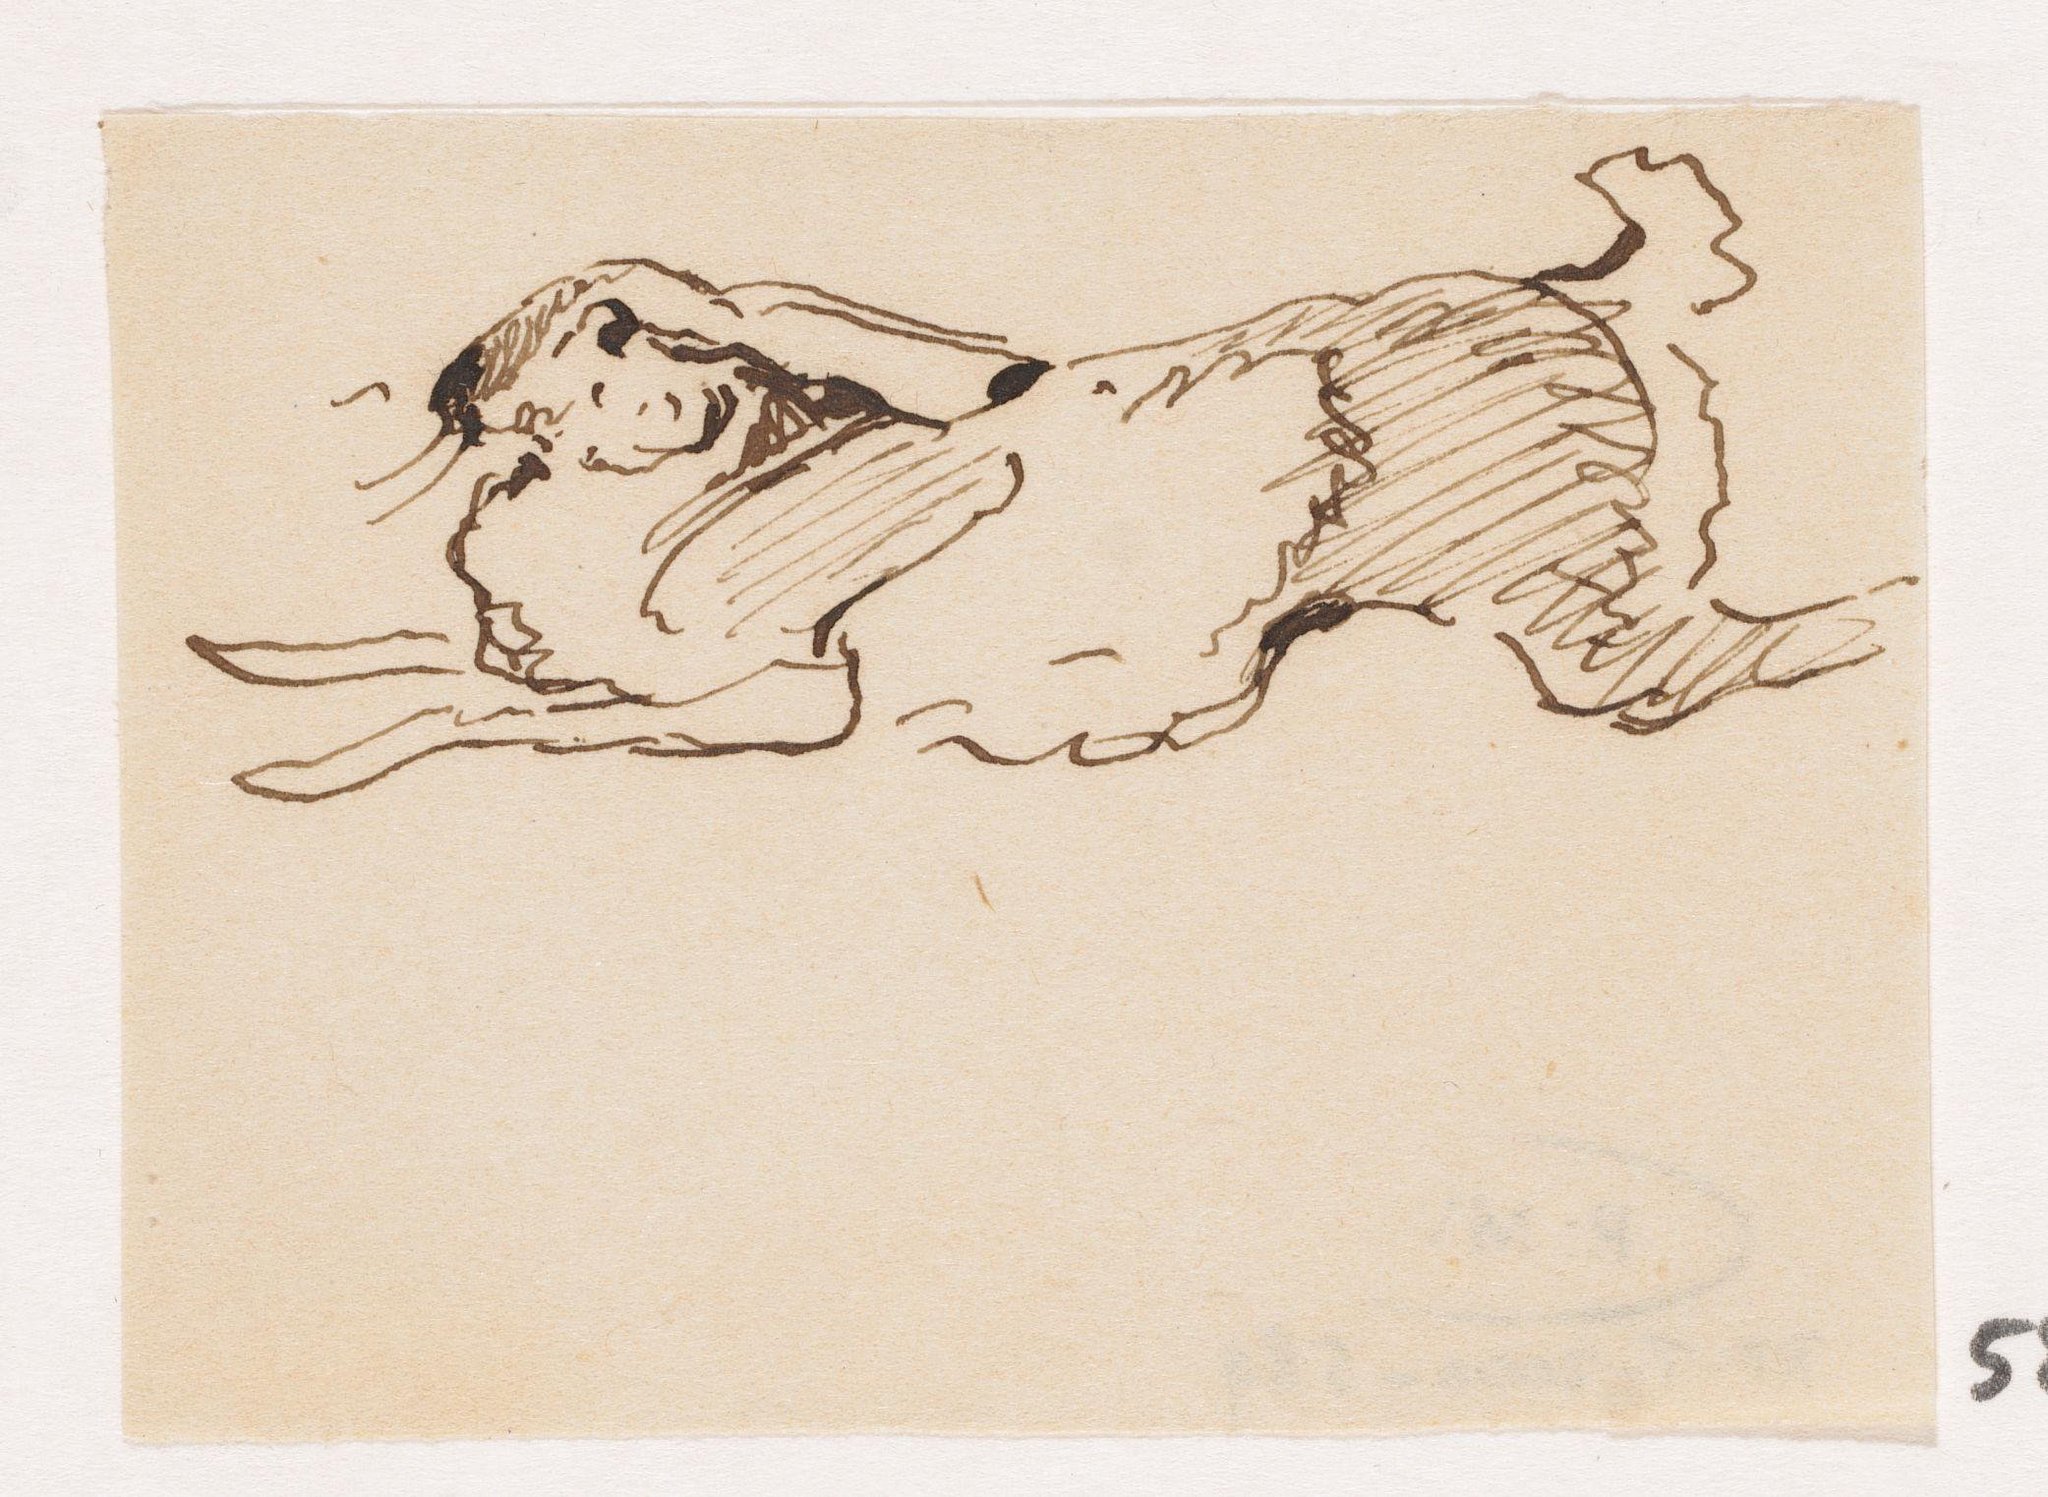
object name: drawing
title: Haas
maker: johannes tavenraat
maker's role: draughtsman, painter, print maker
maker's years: 1809-1881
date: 1840-1880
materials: ink, paper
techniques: pen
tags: rodents: hare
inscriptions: collector's mark: Lugt 2228